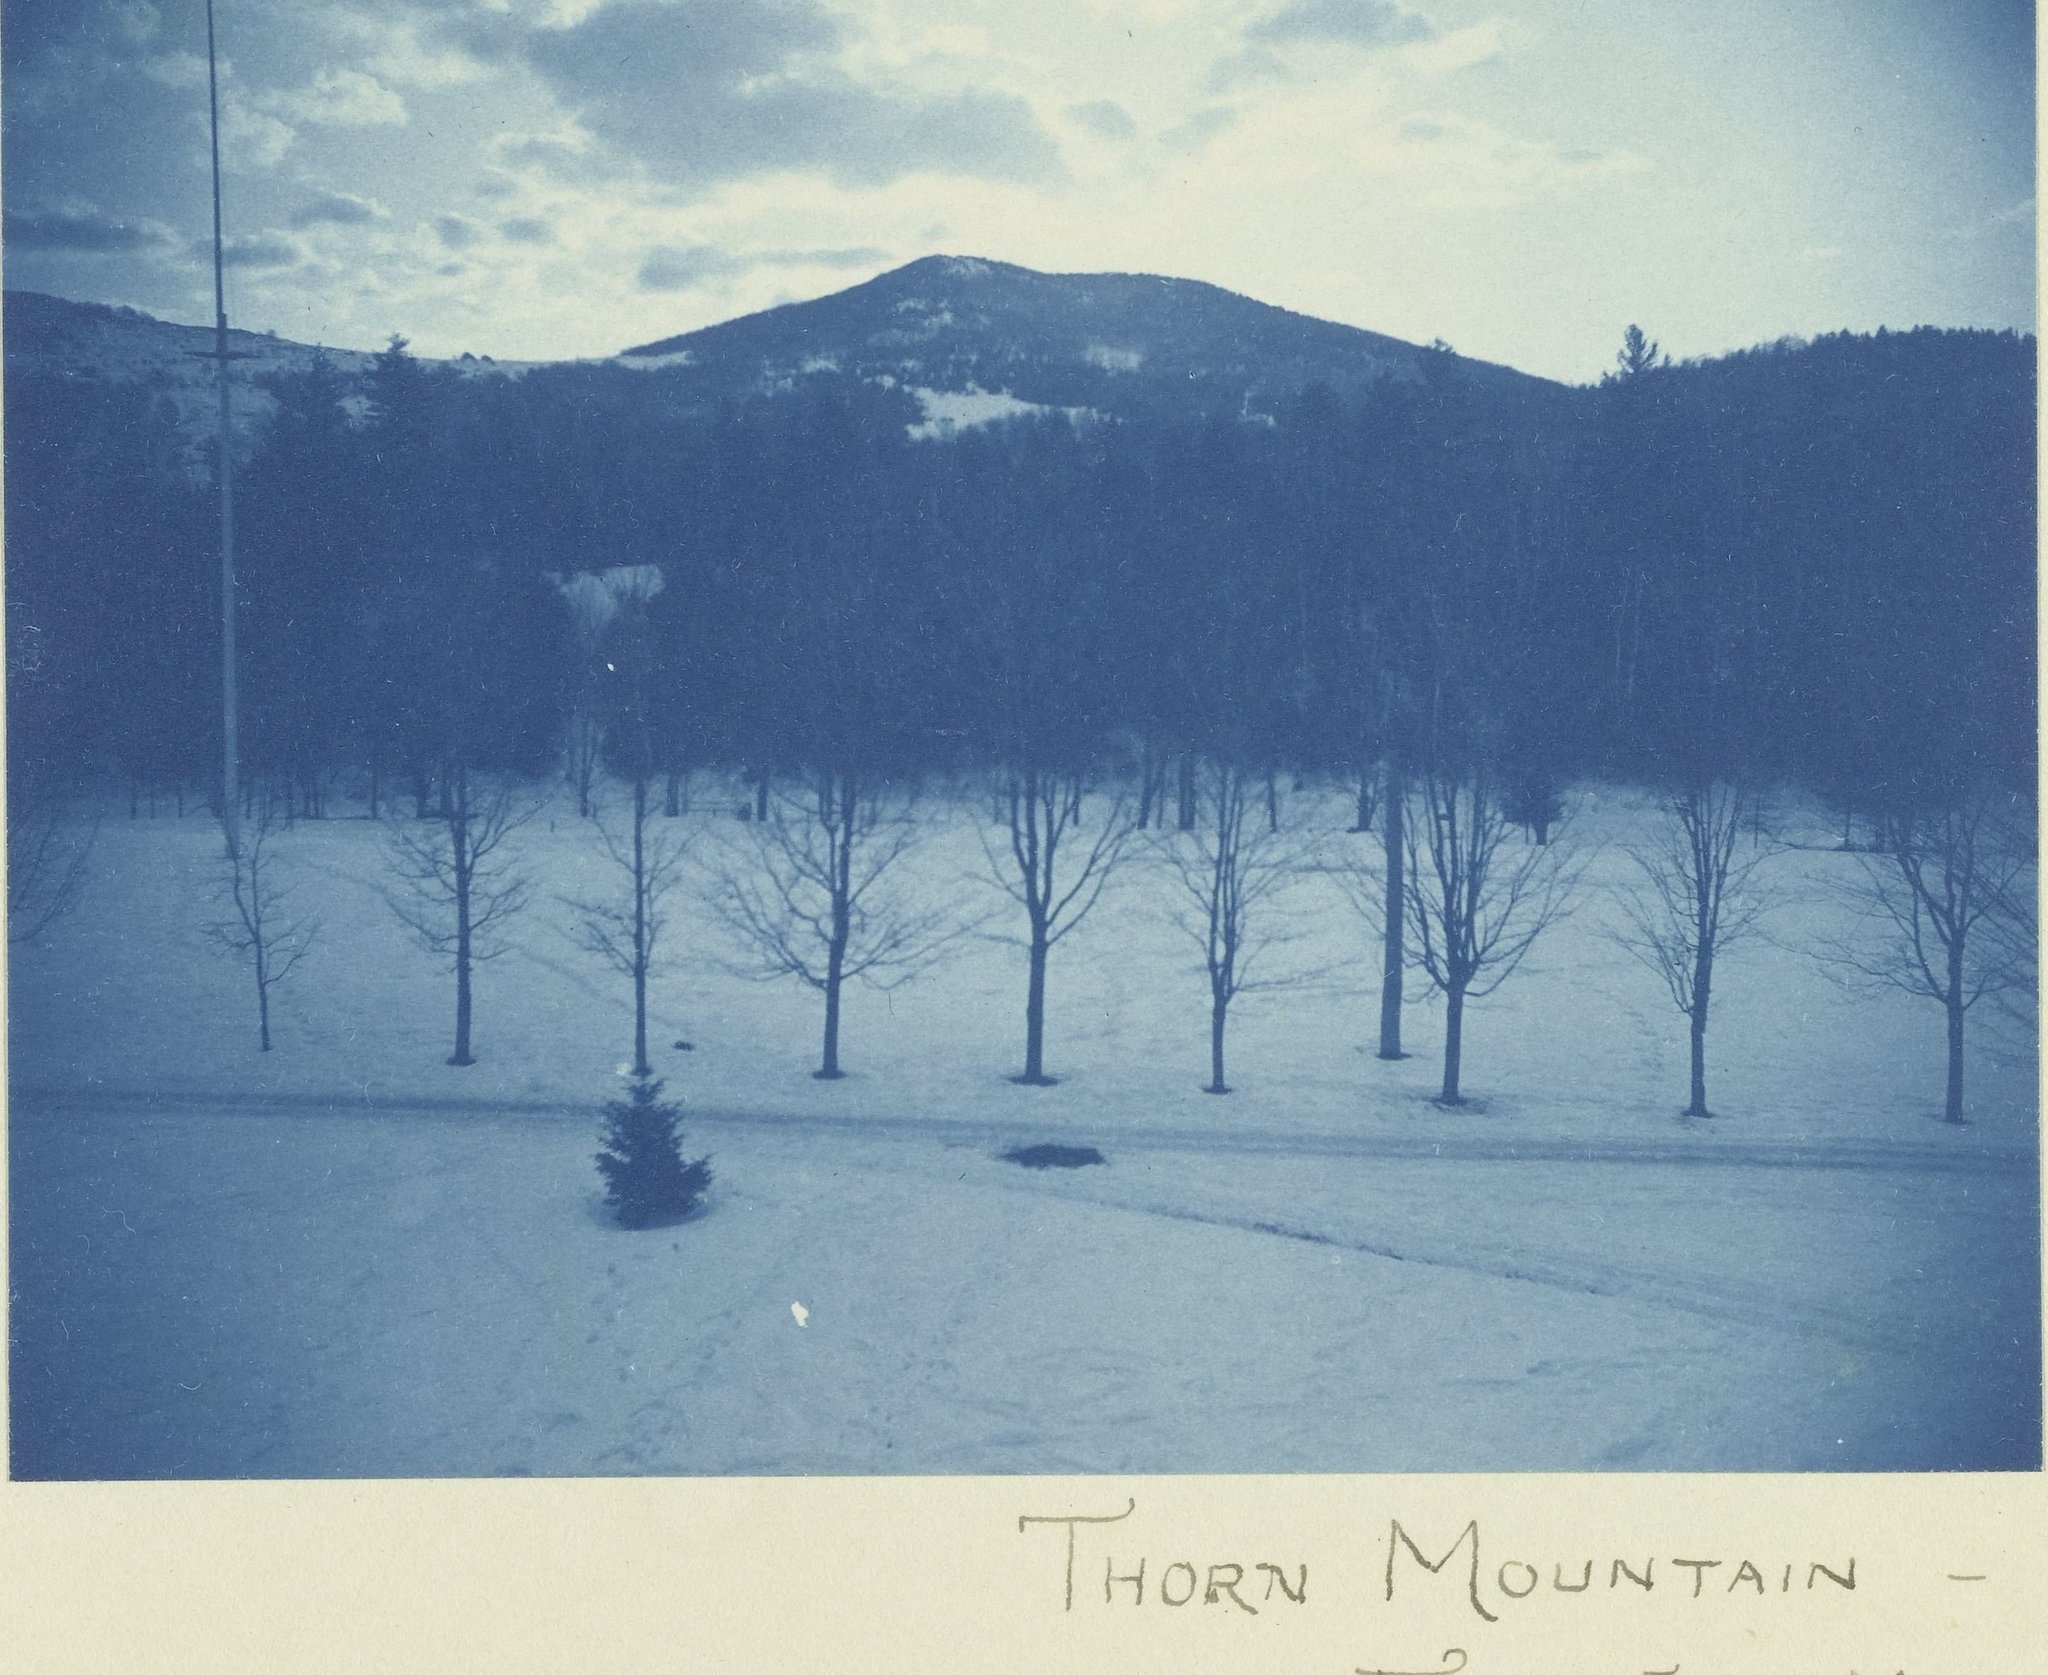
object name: photograph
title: Landschap in de sneeuw: zonsopgang bij Thorn Mountain, gezien vanaf Iron Mountain House, Jackson, NH, Verenigde Staten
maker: charlotte m. endicott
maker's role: fotograaf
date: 1899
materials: photographic support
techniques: cyanotype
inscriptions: title: ‘THORN MOUNTAIN - SUNRISE. / FROM IRON HOUSE MOUNTAIN HOUSE. / FEB. 21. 1899’